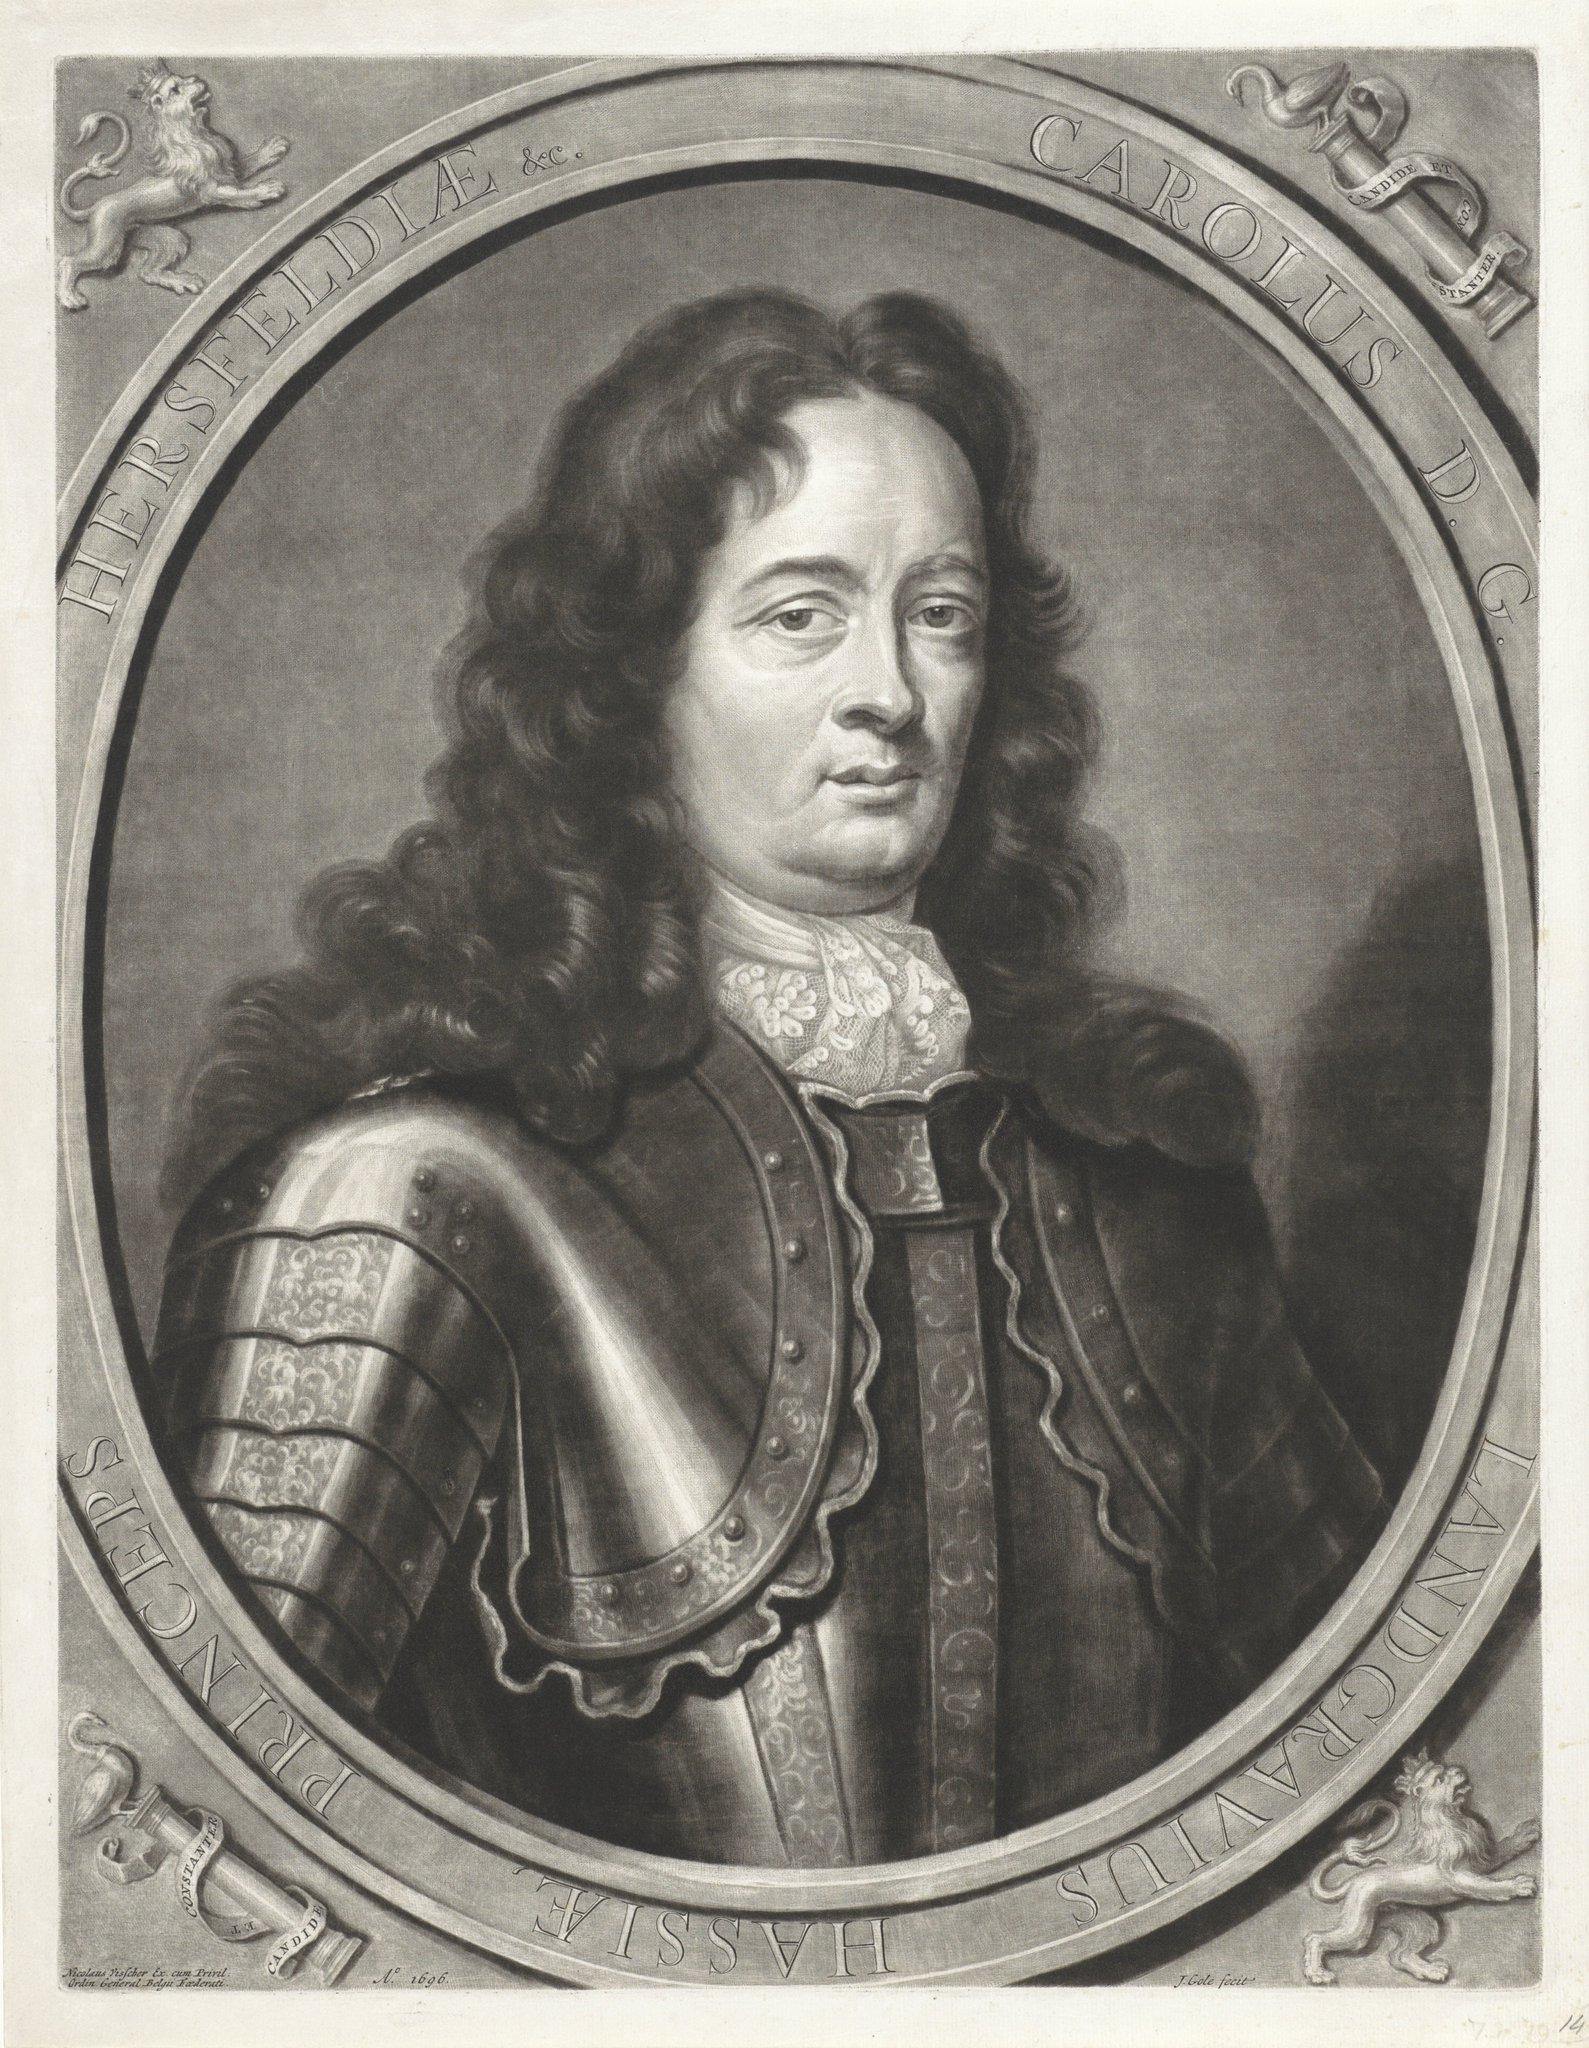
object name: print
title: Portret van Karel I, landgraaf van Hessen-Kassel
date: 1696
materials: paper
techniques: engraving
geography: amsterdam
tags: karel i (landgraaf van hessen-kassel)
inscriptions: collector's mark: Lugt 240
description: Karel I, landgraaf van Hessen-Kassel. Hij draagt een harnas en een kraag van kant.